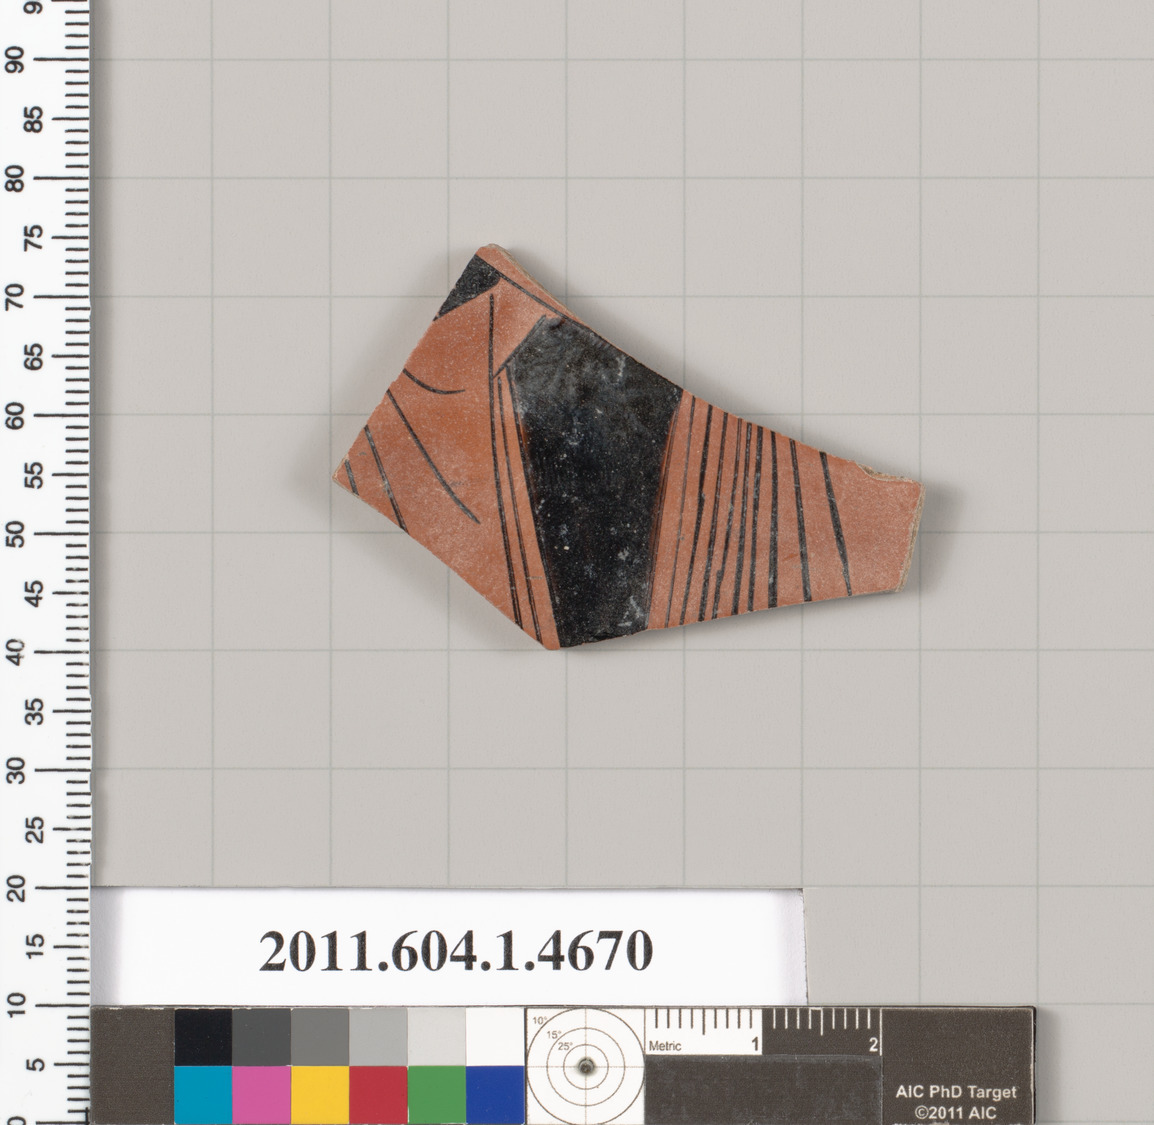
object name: kylix fragment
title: Terracotta fragment of a kylix (drinking cup)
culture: greek, attic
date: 475-451 BCE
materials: terracotta